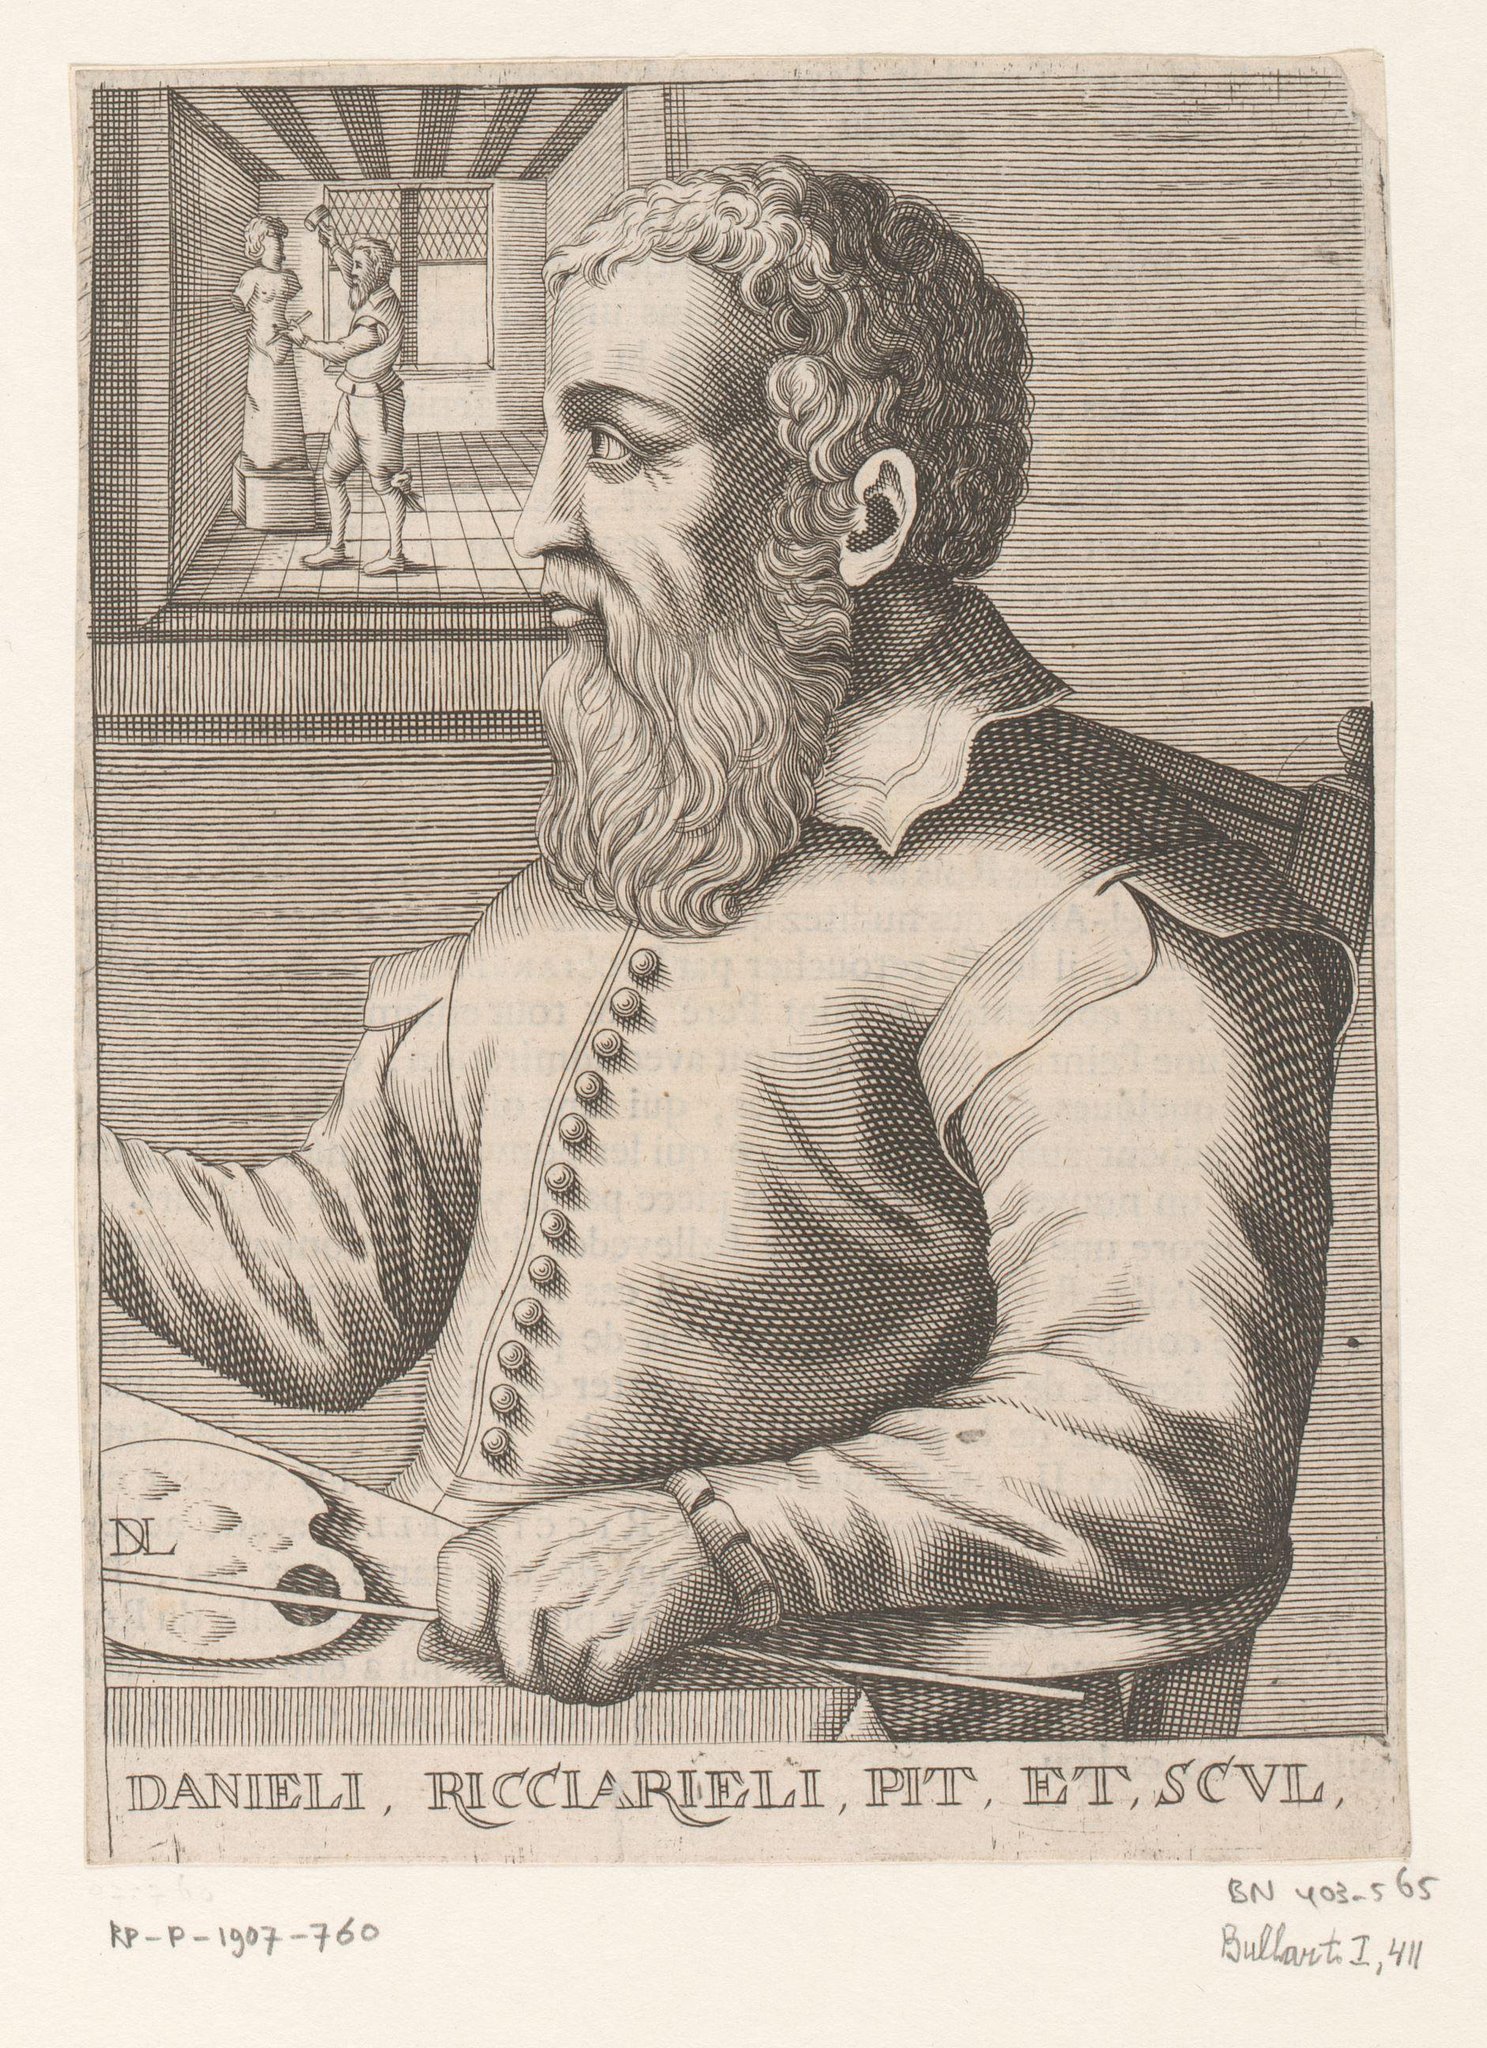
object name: book illustration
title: Danieli, Ricciarieli, Pit, et, Scul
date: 1682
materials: paper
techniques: engraving, letterpress printing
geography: brussels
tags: rome, draughtsman, daniele da volterra, historical persons, portrait, self-portrait of artist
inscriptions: collector's mark: Lugt 2228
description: Prent gebruikt voor: Bullart, Isaac. Académie des Sciences et Arts contenant les vies et éloges his. des hommes illustres qui ont excellé en ces professions depuis environ quatre siècles. Brussel: François Foppens, 1682. Het boek werd in 1682 eveneens in Amsterdam uitgegeven door de erfgenamen van Daniel Elzevier. Ieder portret betreft een illustratie bij de biografie van een kunstenaar of geleerde. De meeste portretten werden door Nicolas de Larmessin vervaardigd (162), 93 door De Boulonois en een derde door ongeïdentificeerde prentmakers. Dit betreft een illustratie op p. 411, deel I.